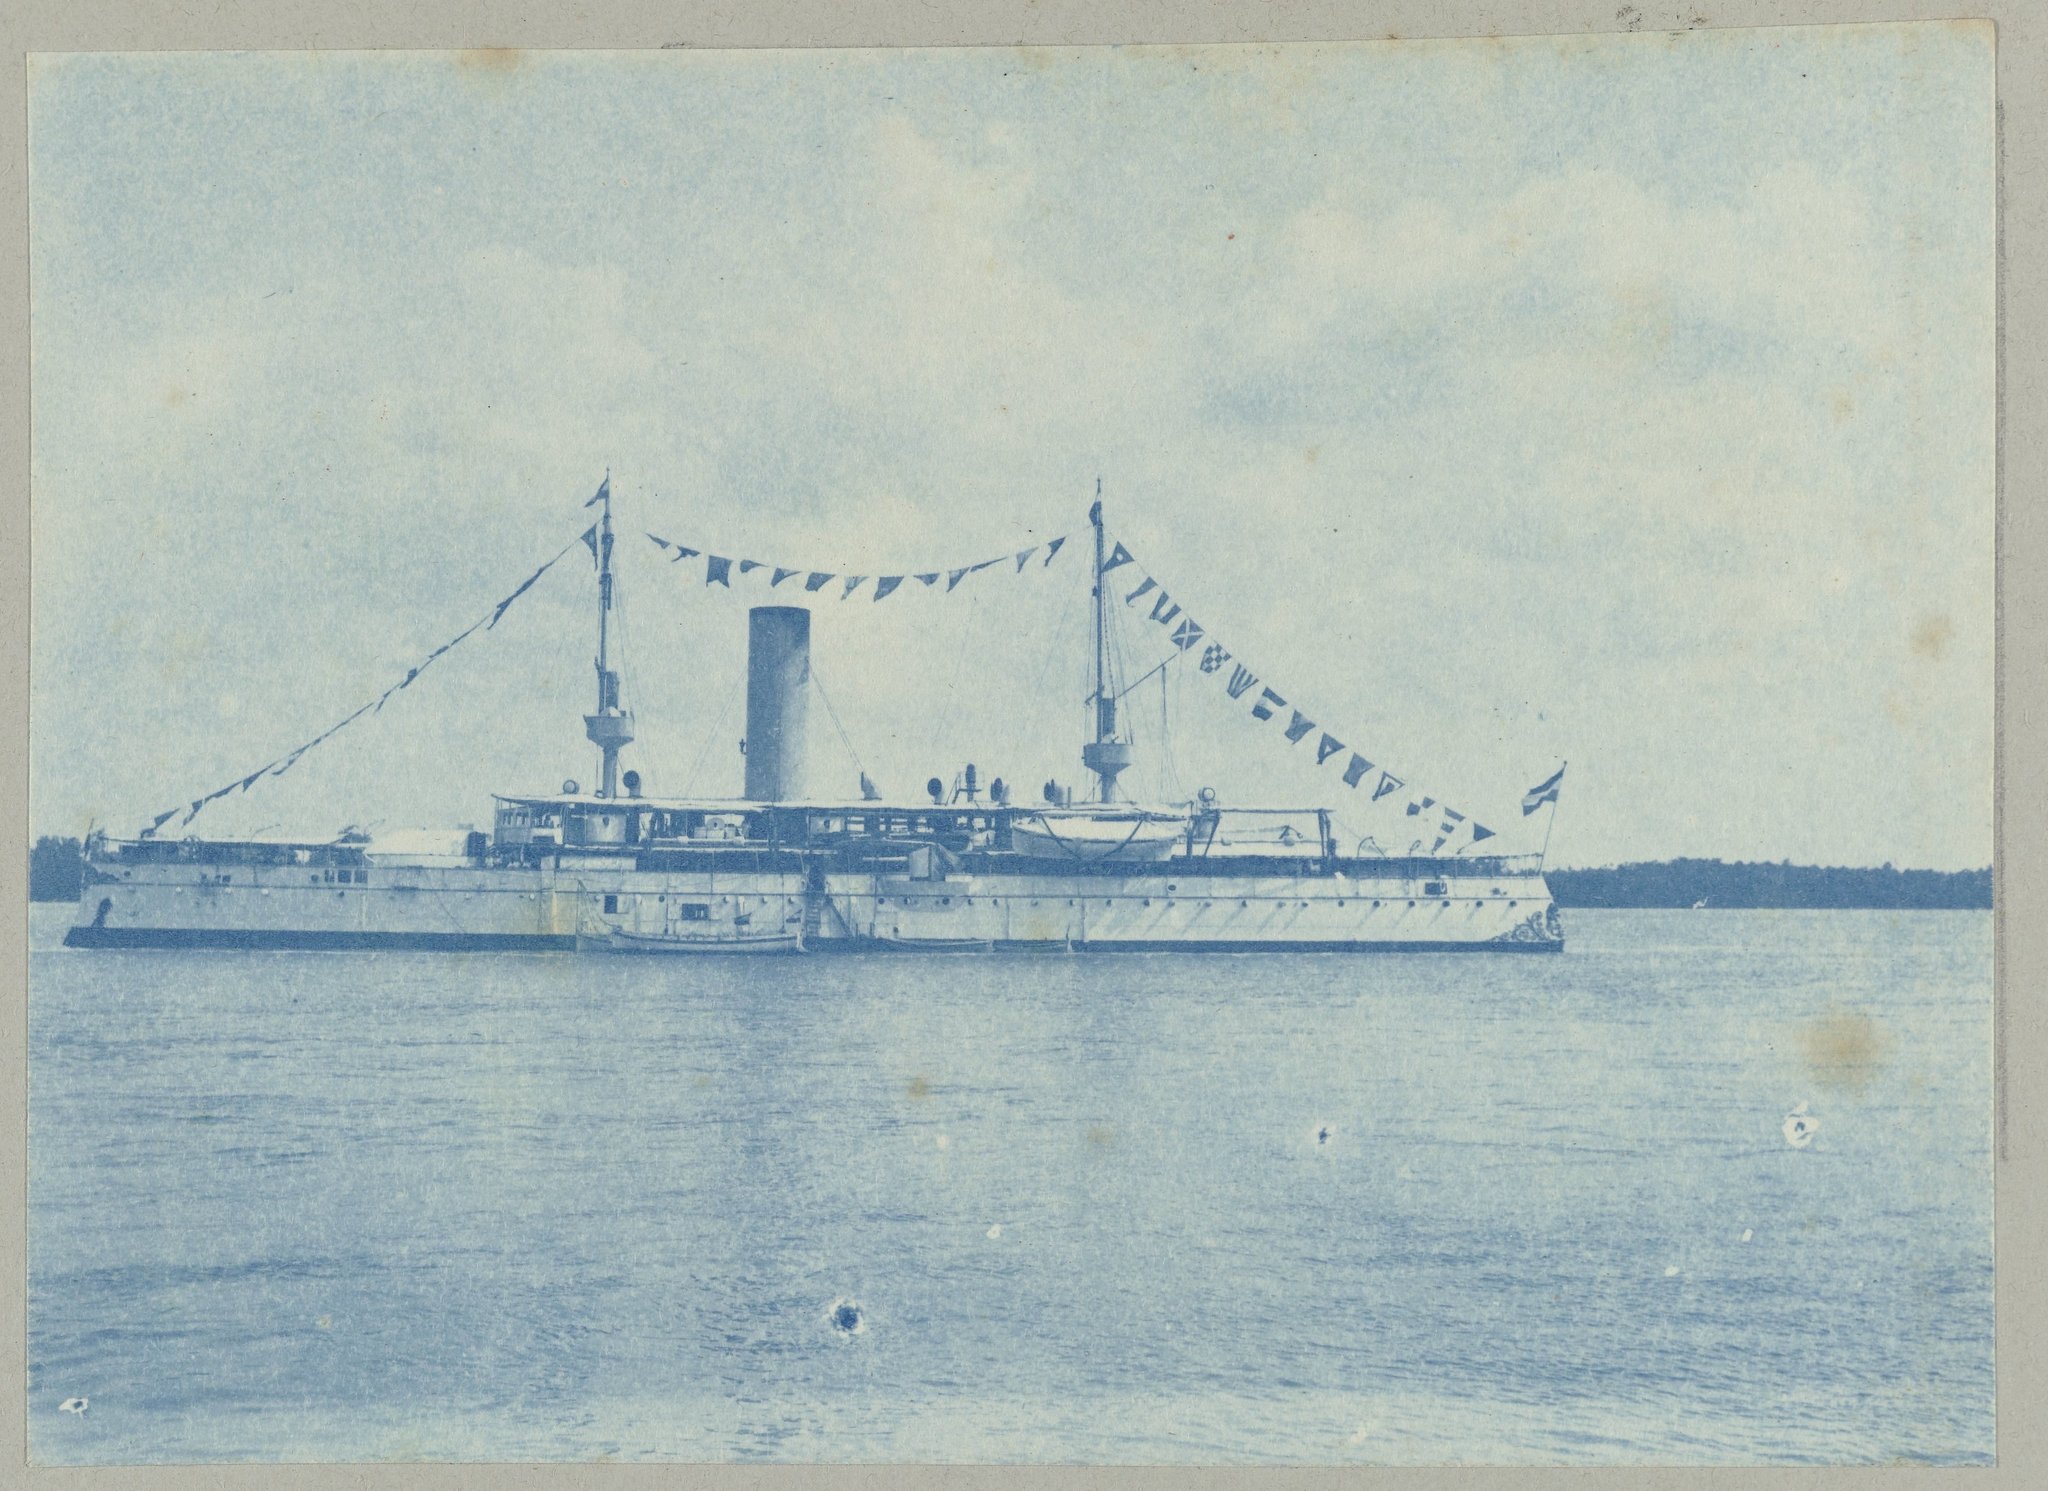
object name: photograph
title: De Kortenaer op Koninginnedag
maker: hendrik doijer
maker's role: engineer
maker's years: 1863-1925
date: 1903-1910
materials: photographic support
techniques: cyanotype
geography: suriname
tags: suriname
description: Het pantserschip de Kortenaer versierd met vlaggetjes tijdens de viering van Koninginnedag op 31 augustus, te Paramaribo. Onderdeel van het fotoalbum Souvenir de Voyage (deel 2), over het leven van de familie Doijer in en rond de plantage Ma Retraite in Suriname in de jaren 1903-1910.